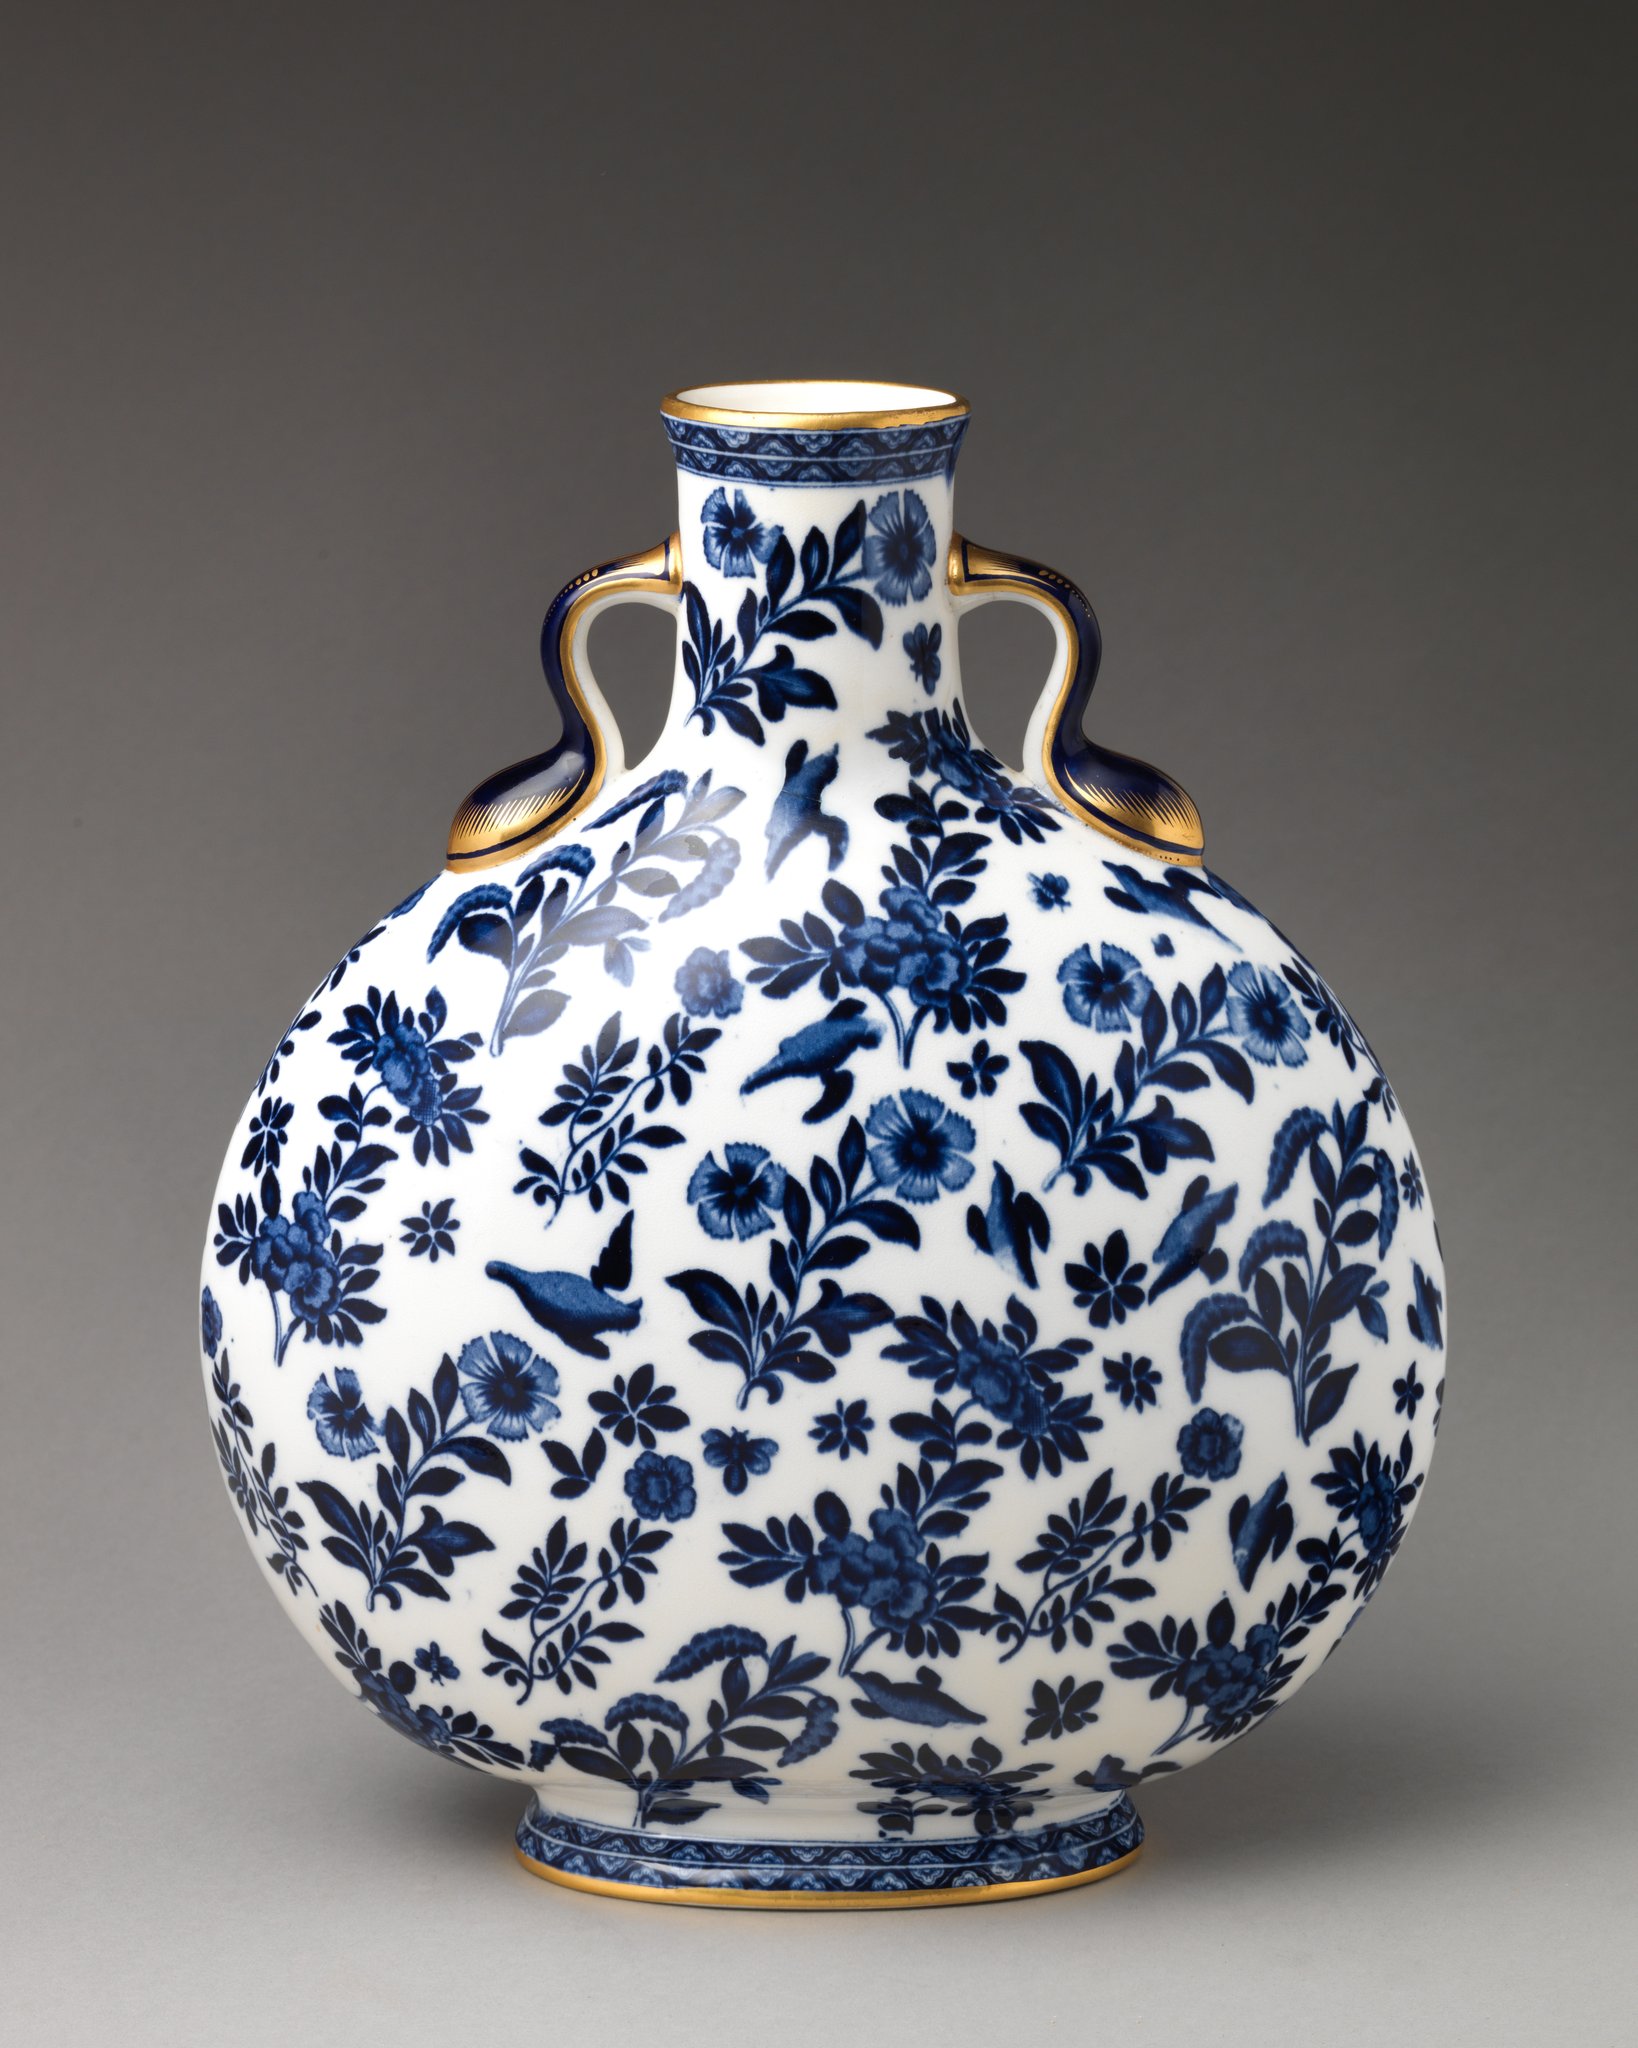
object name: moon flask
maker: minton(s)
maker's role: maker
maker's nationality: british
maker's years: 1793-2001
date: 1870-1880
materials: bone china, enamel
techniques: gilding